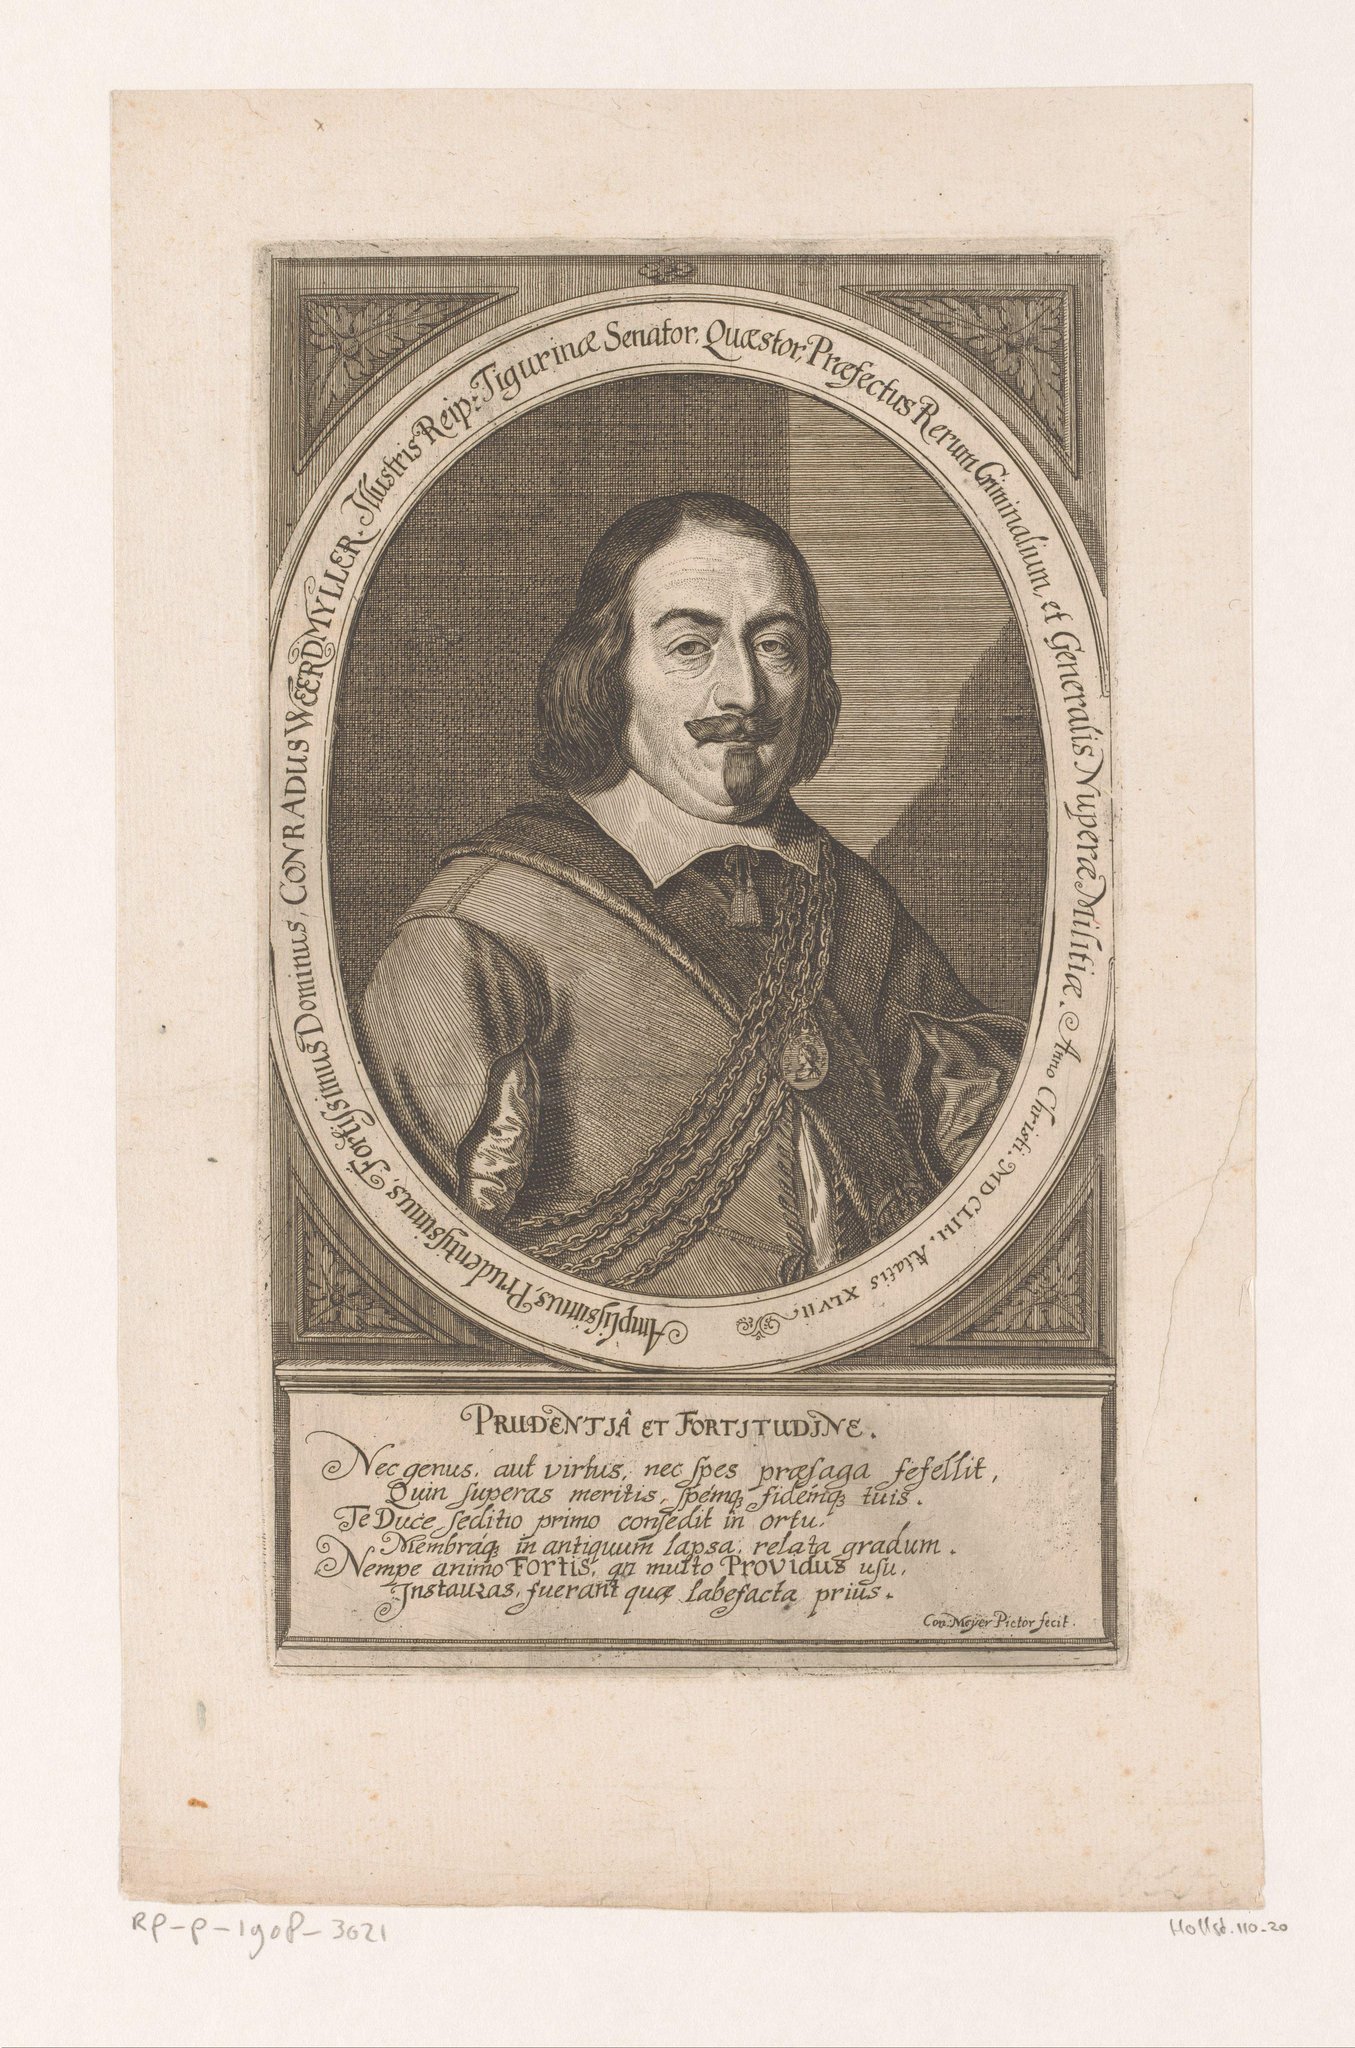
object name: print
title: Portret van Hans Conrad Werdmüller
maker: conrad meyer (i)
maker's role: painter, print maker, publisher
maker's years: 1618-1689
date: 1653-1689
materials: paper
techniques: engraving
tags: mayor, mayor, burgomaster, other non-personal regalia, e.g. mayor chain, historical persons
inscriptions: collector's mark: Lugt 2228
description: Onderdeel van een serie van 67(?) portretten van burgemeesters van Zürich. Zie Hollstein German 110, 1-26.